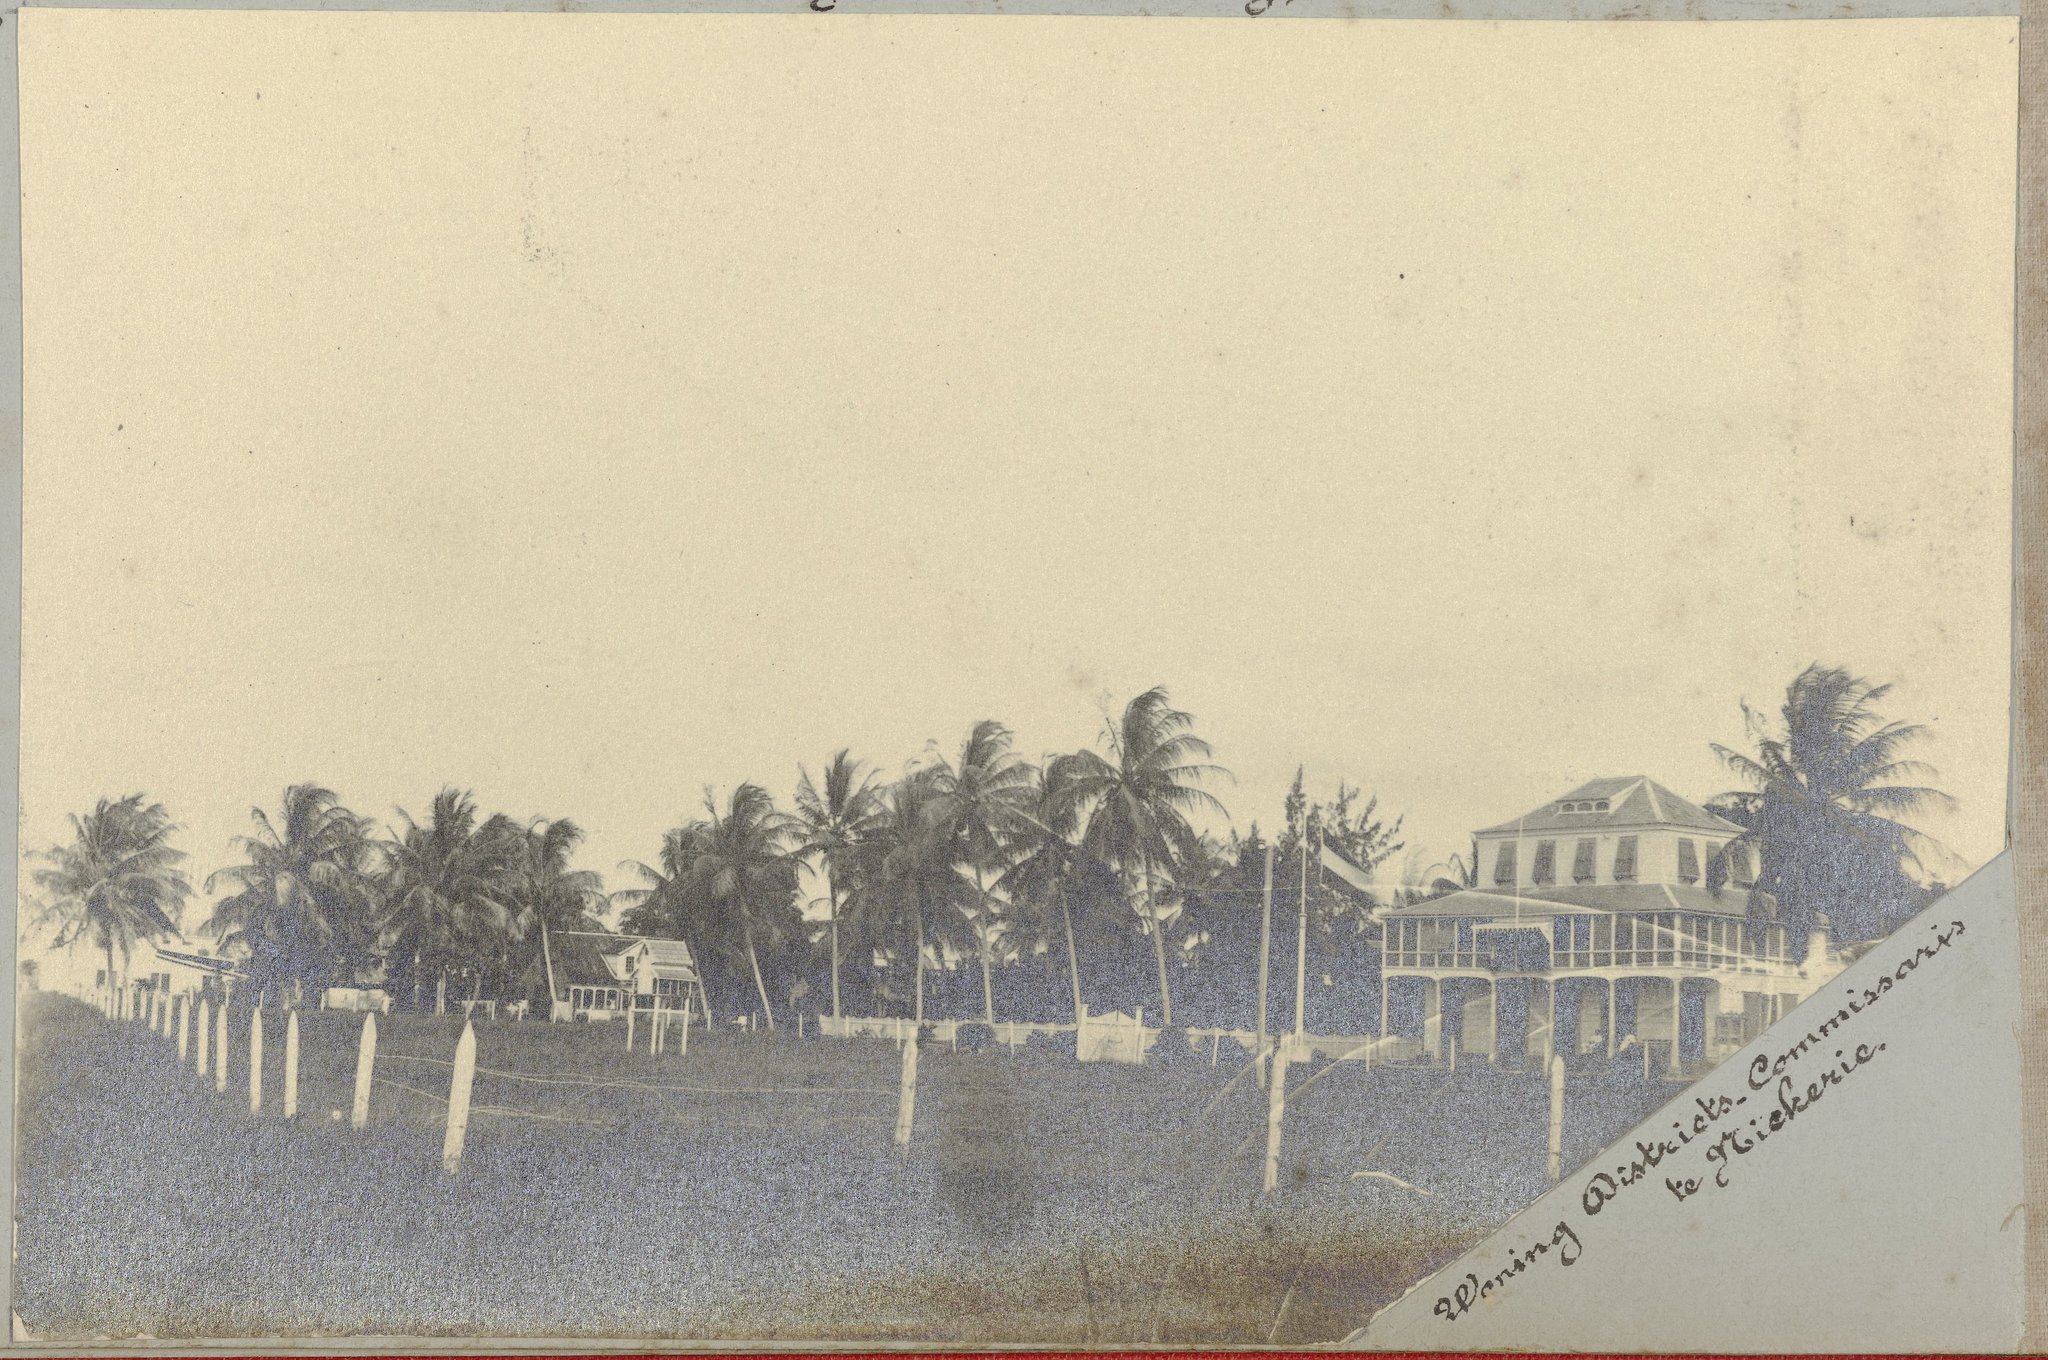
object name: photograph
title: Woning Districts-Commissaris te Nickerie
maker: gomez burke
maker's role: fotograaf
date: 1891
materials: photographic support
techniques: gelatin silver print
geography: suriname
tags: suriname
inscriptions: inscription: ‘G.B. / Woning Districts-Commissaris te Nickerie.’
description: Gezicht op de woning van de districtscommissaris te Nickerie, voor het huis een tuin met hek en palmbomen. Onderdeel van het fotoalbum Souvenir de Voyage (deel 4), over het leven van de familie Dooyer in en rond de plantage Ma Retraite in Suriname in de jaren 1906-1913.